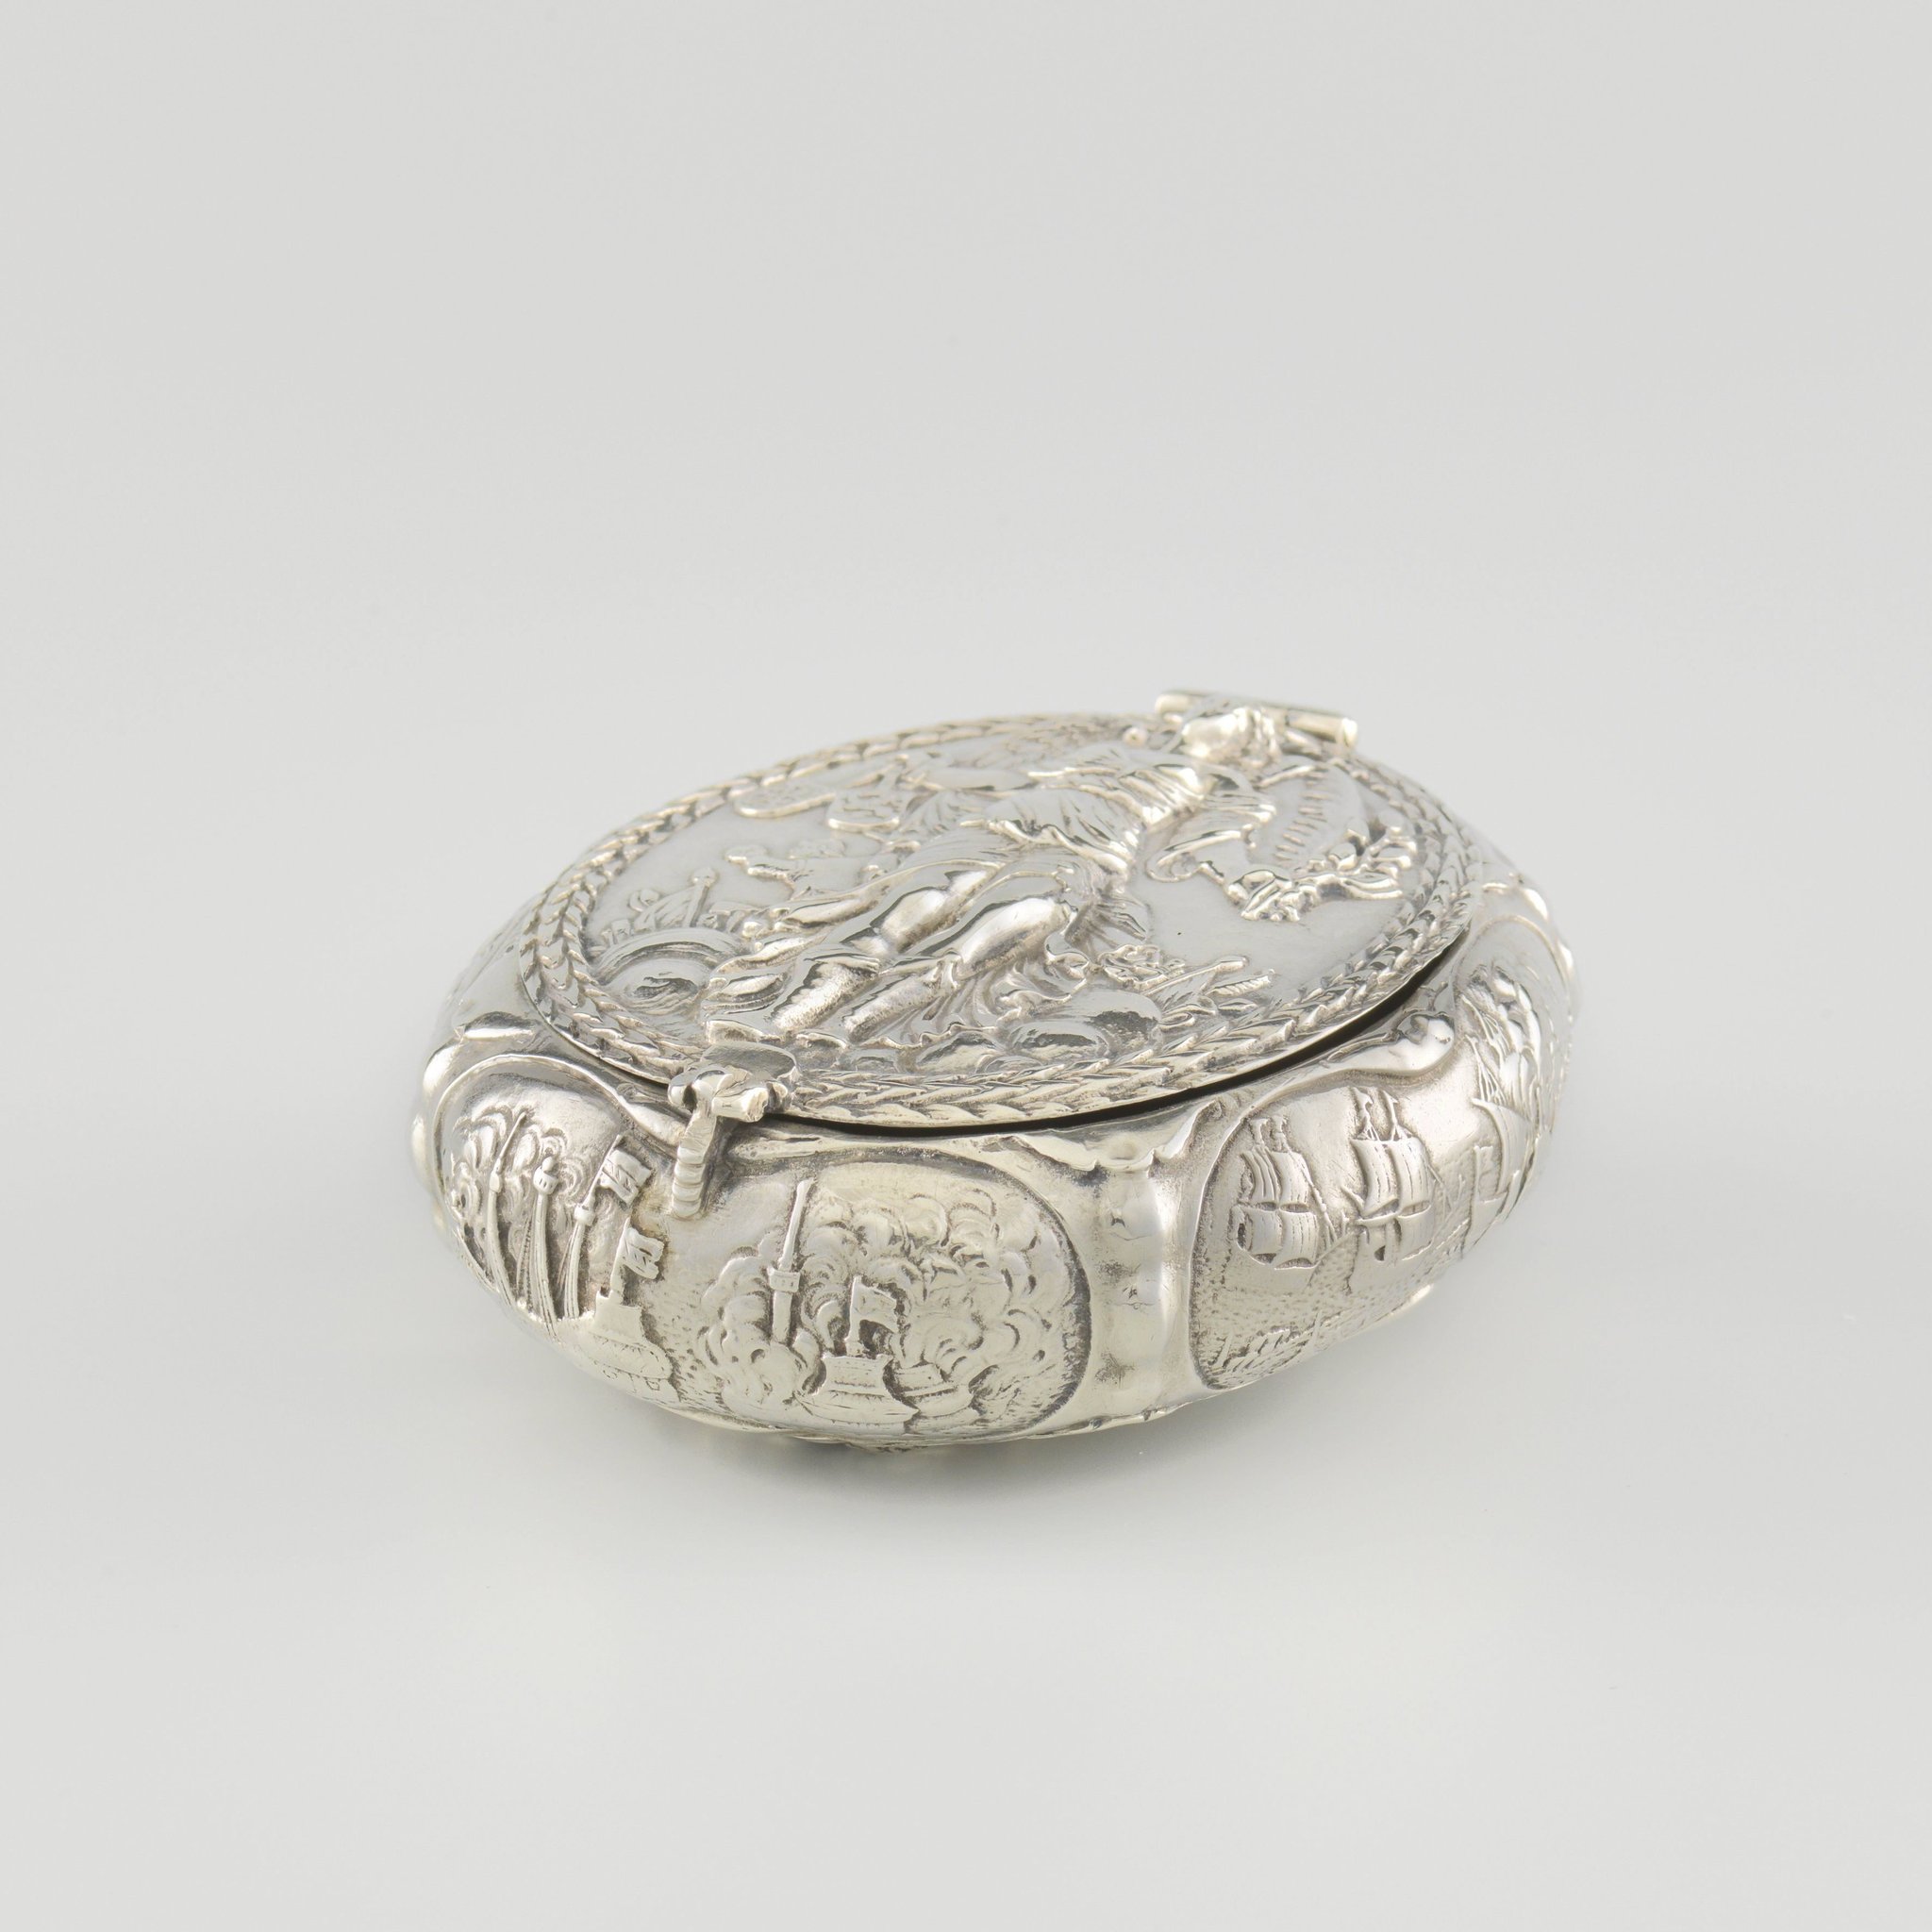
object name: tobacco box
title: Vrede van Breda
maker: Anonymous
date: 1667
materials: silver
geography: amsterdam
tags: personifications of countries, nations, states, districts, etc., symbols, allegories of peace, 'pax'; 'pace' (ripa), signing of peace treaty, concluding the peace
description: De ovale doos heeft een scharnierend deksel, en is versierd met ovale medaillons. Op de voorzijde is de Hollandse Maagd aangebracht die de Nijd vertrapt, op de keerzijde de Vrede, omgeven door de wapens van het koninkrijk Engeland en de Republiek, rondom zijn, gevat in kwabmotieven, zeeslagen afgebeeld. In de binnenzijde is een stopper voor een pijp aangebracht.